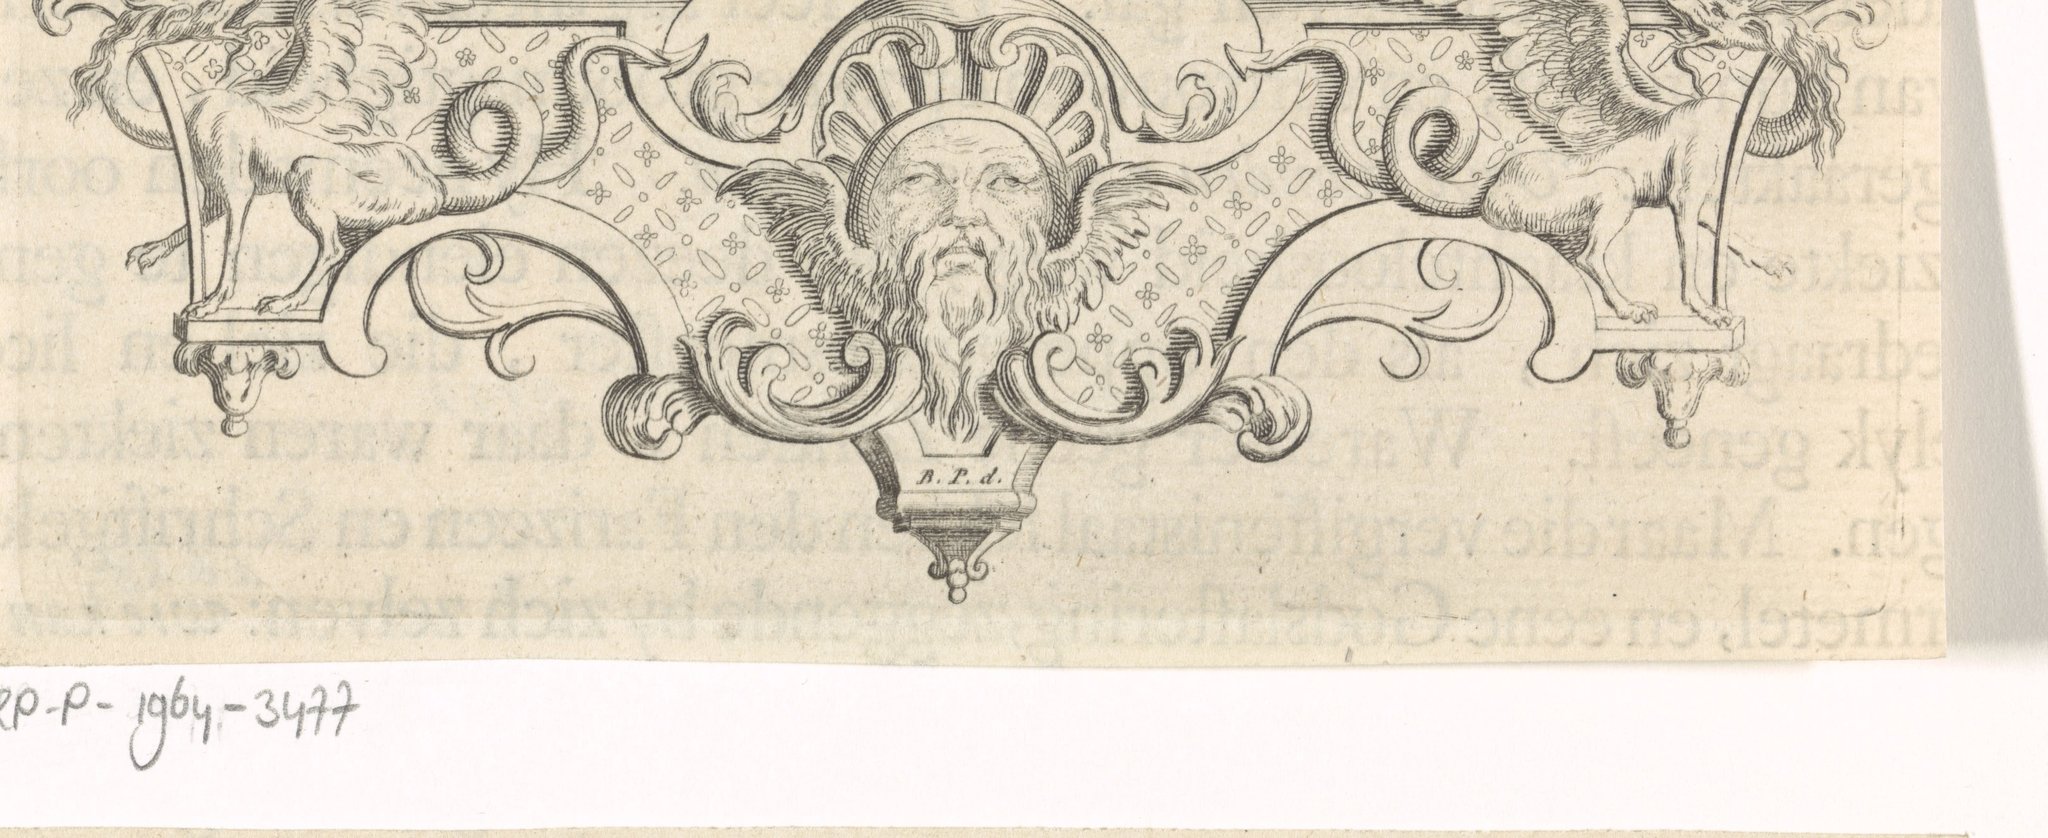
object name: book illustration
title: Vignet met een mascaron, rolwerk en hybride wezens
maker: bernard picart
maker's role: draughtsman, print maker, publisher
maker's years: 1673-1733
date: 1683-1733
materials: paper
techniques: etching, letterpress printing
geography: amsterdam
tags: scrollwork, strapwork ~ ornament, mask, mascaron ~ ornament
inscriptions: collector's mark: Lugt 2228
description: Prent oorspronkelijk bedoeld voor: Figures de la Bible. Amsterdam, Bernard Picart, 1720. Prent ook gebruikt in: Taferelen der voornaamste geschiedenissen van het Oude en Nieuwe Testament (...) door de vermaarde kunstenaars Hoet, Houbraken, en Picart getekent (...) en met beschrijvingen uitgebreid. Den Haag: Pieter de Hondt, 1728. Prent kan mogelijk ook zijn gebruikt in andere bijbels.